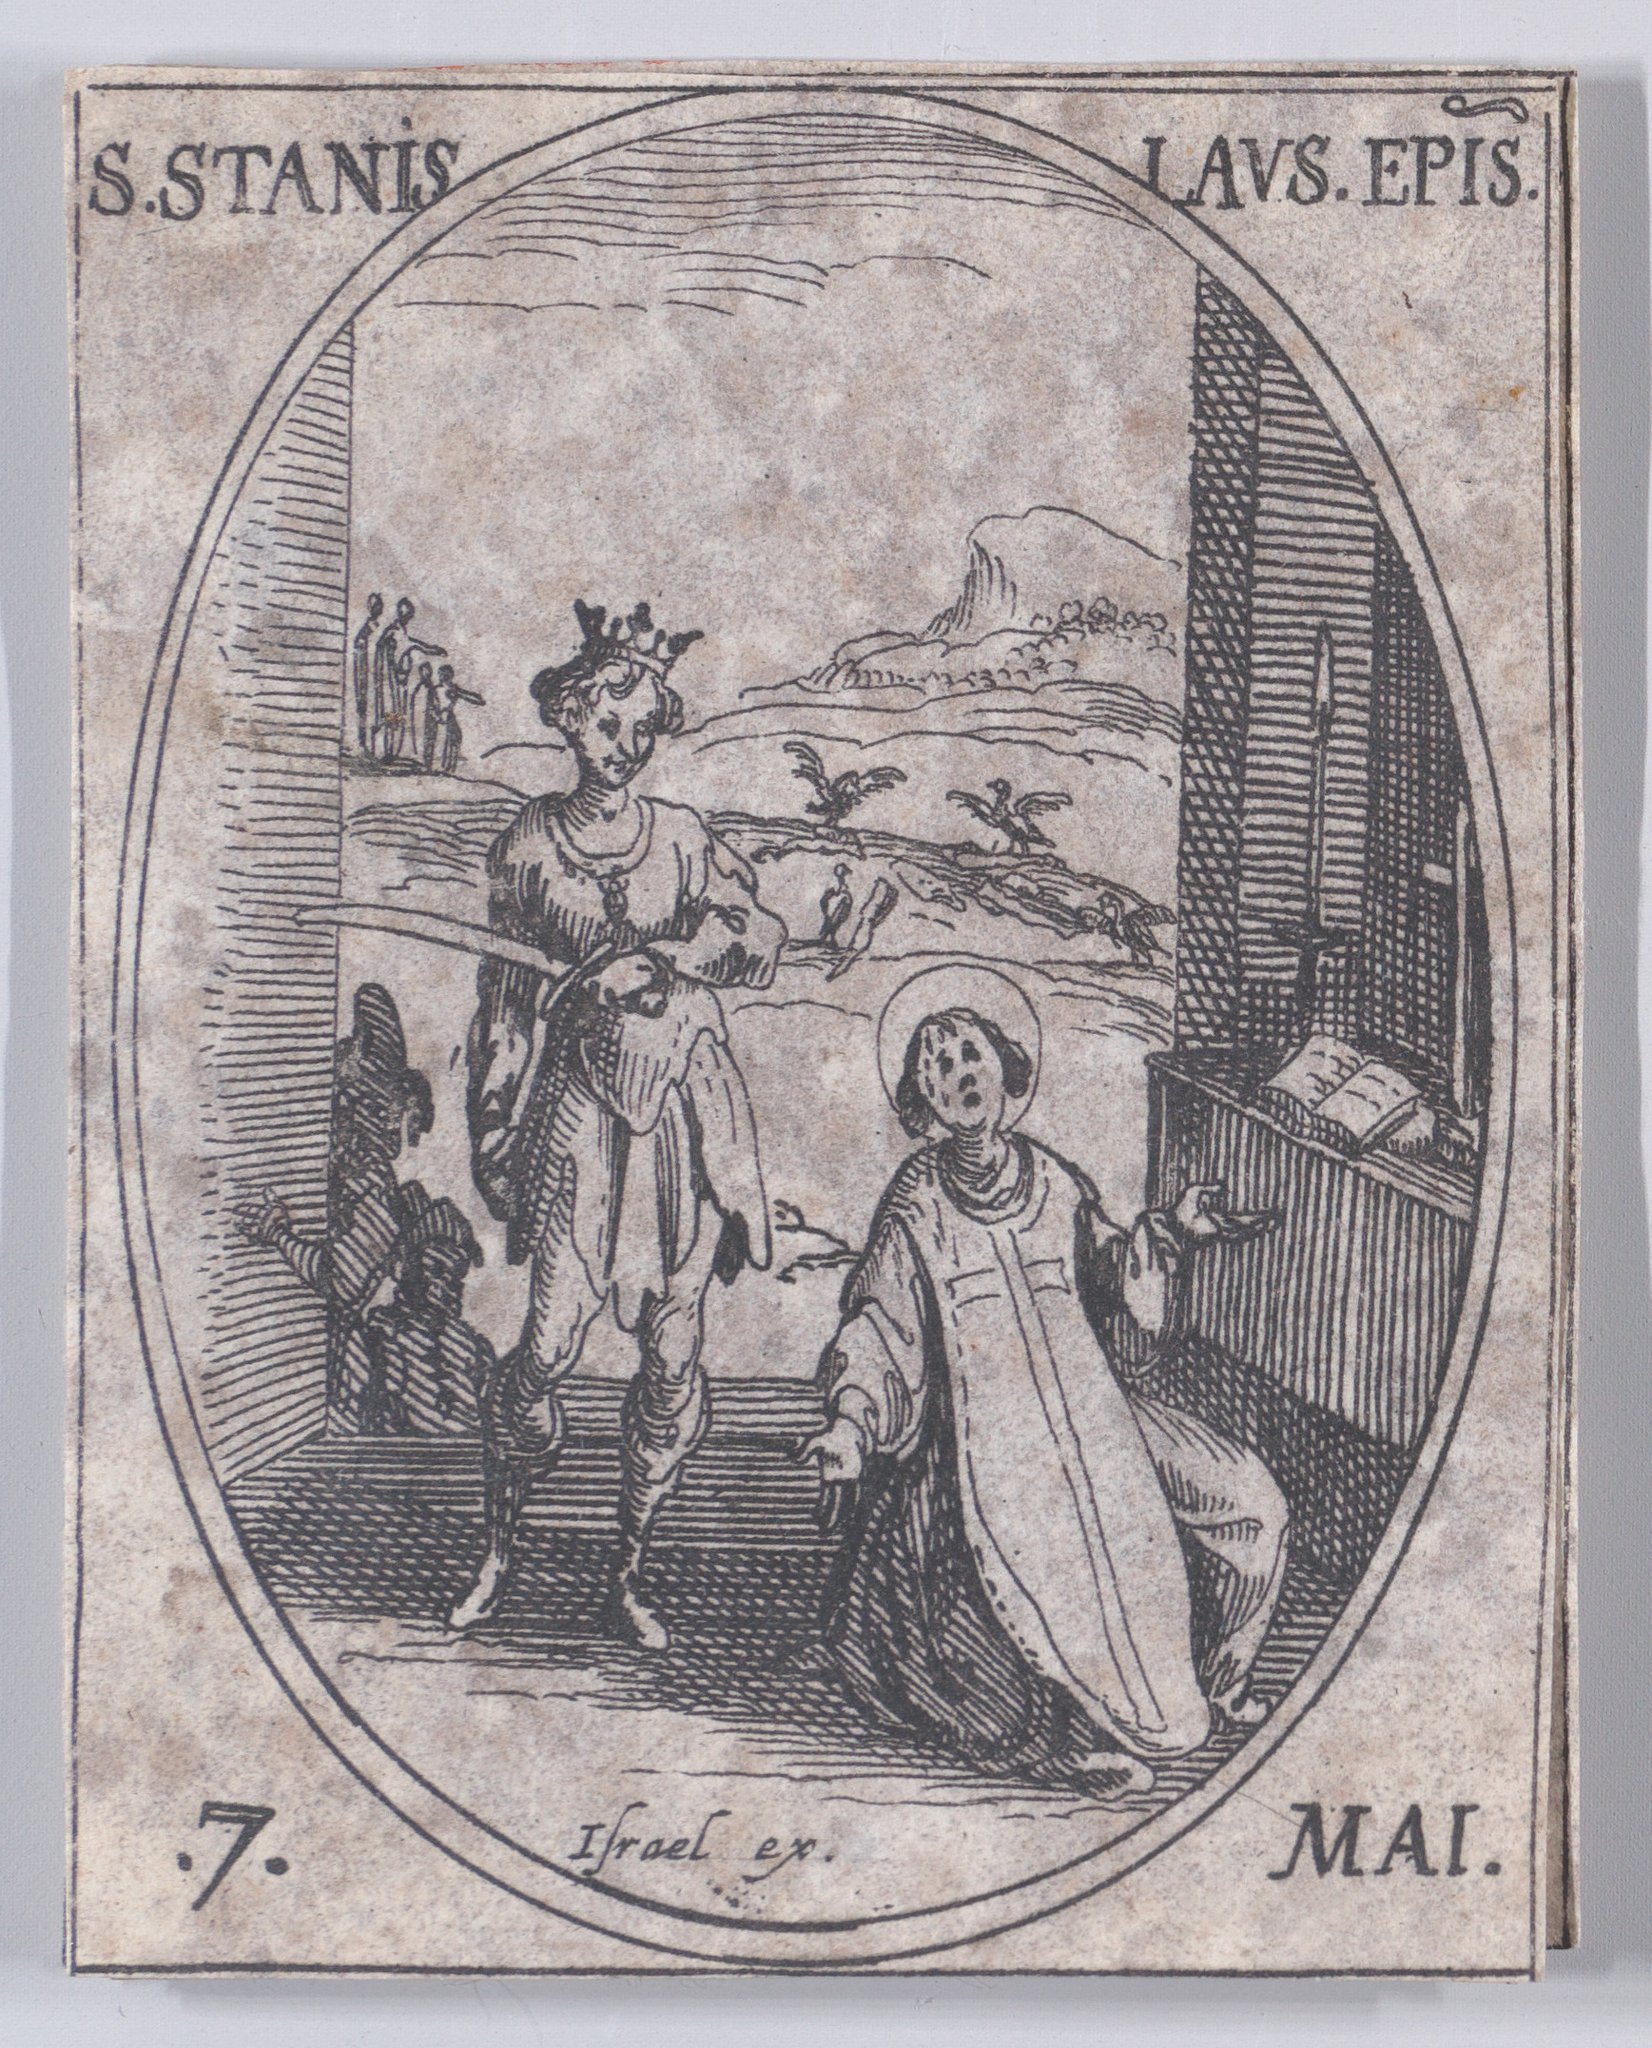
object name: print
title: S. Stanislas, évêque (St. Stanislaus, Bishop), May 7th, from "Les Images De Tous Les Saincts et Saintes de L'Année" (Images of All of the Saints and Religious Events of the Year)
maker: jacques callot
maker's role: artist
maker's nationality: french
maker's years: 1592-1635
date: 1636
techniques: etching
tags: men,saints